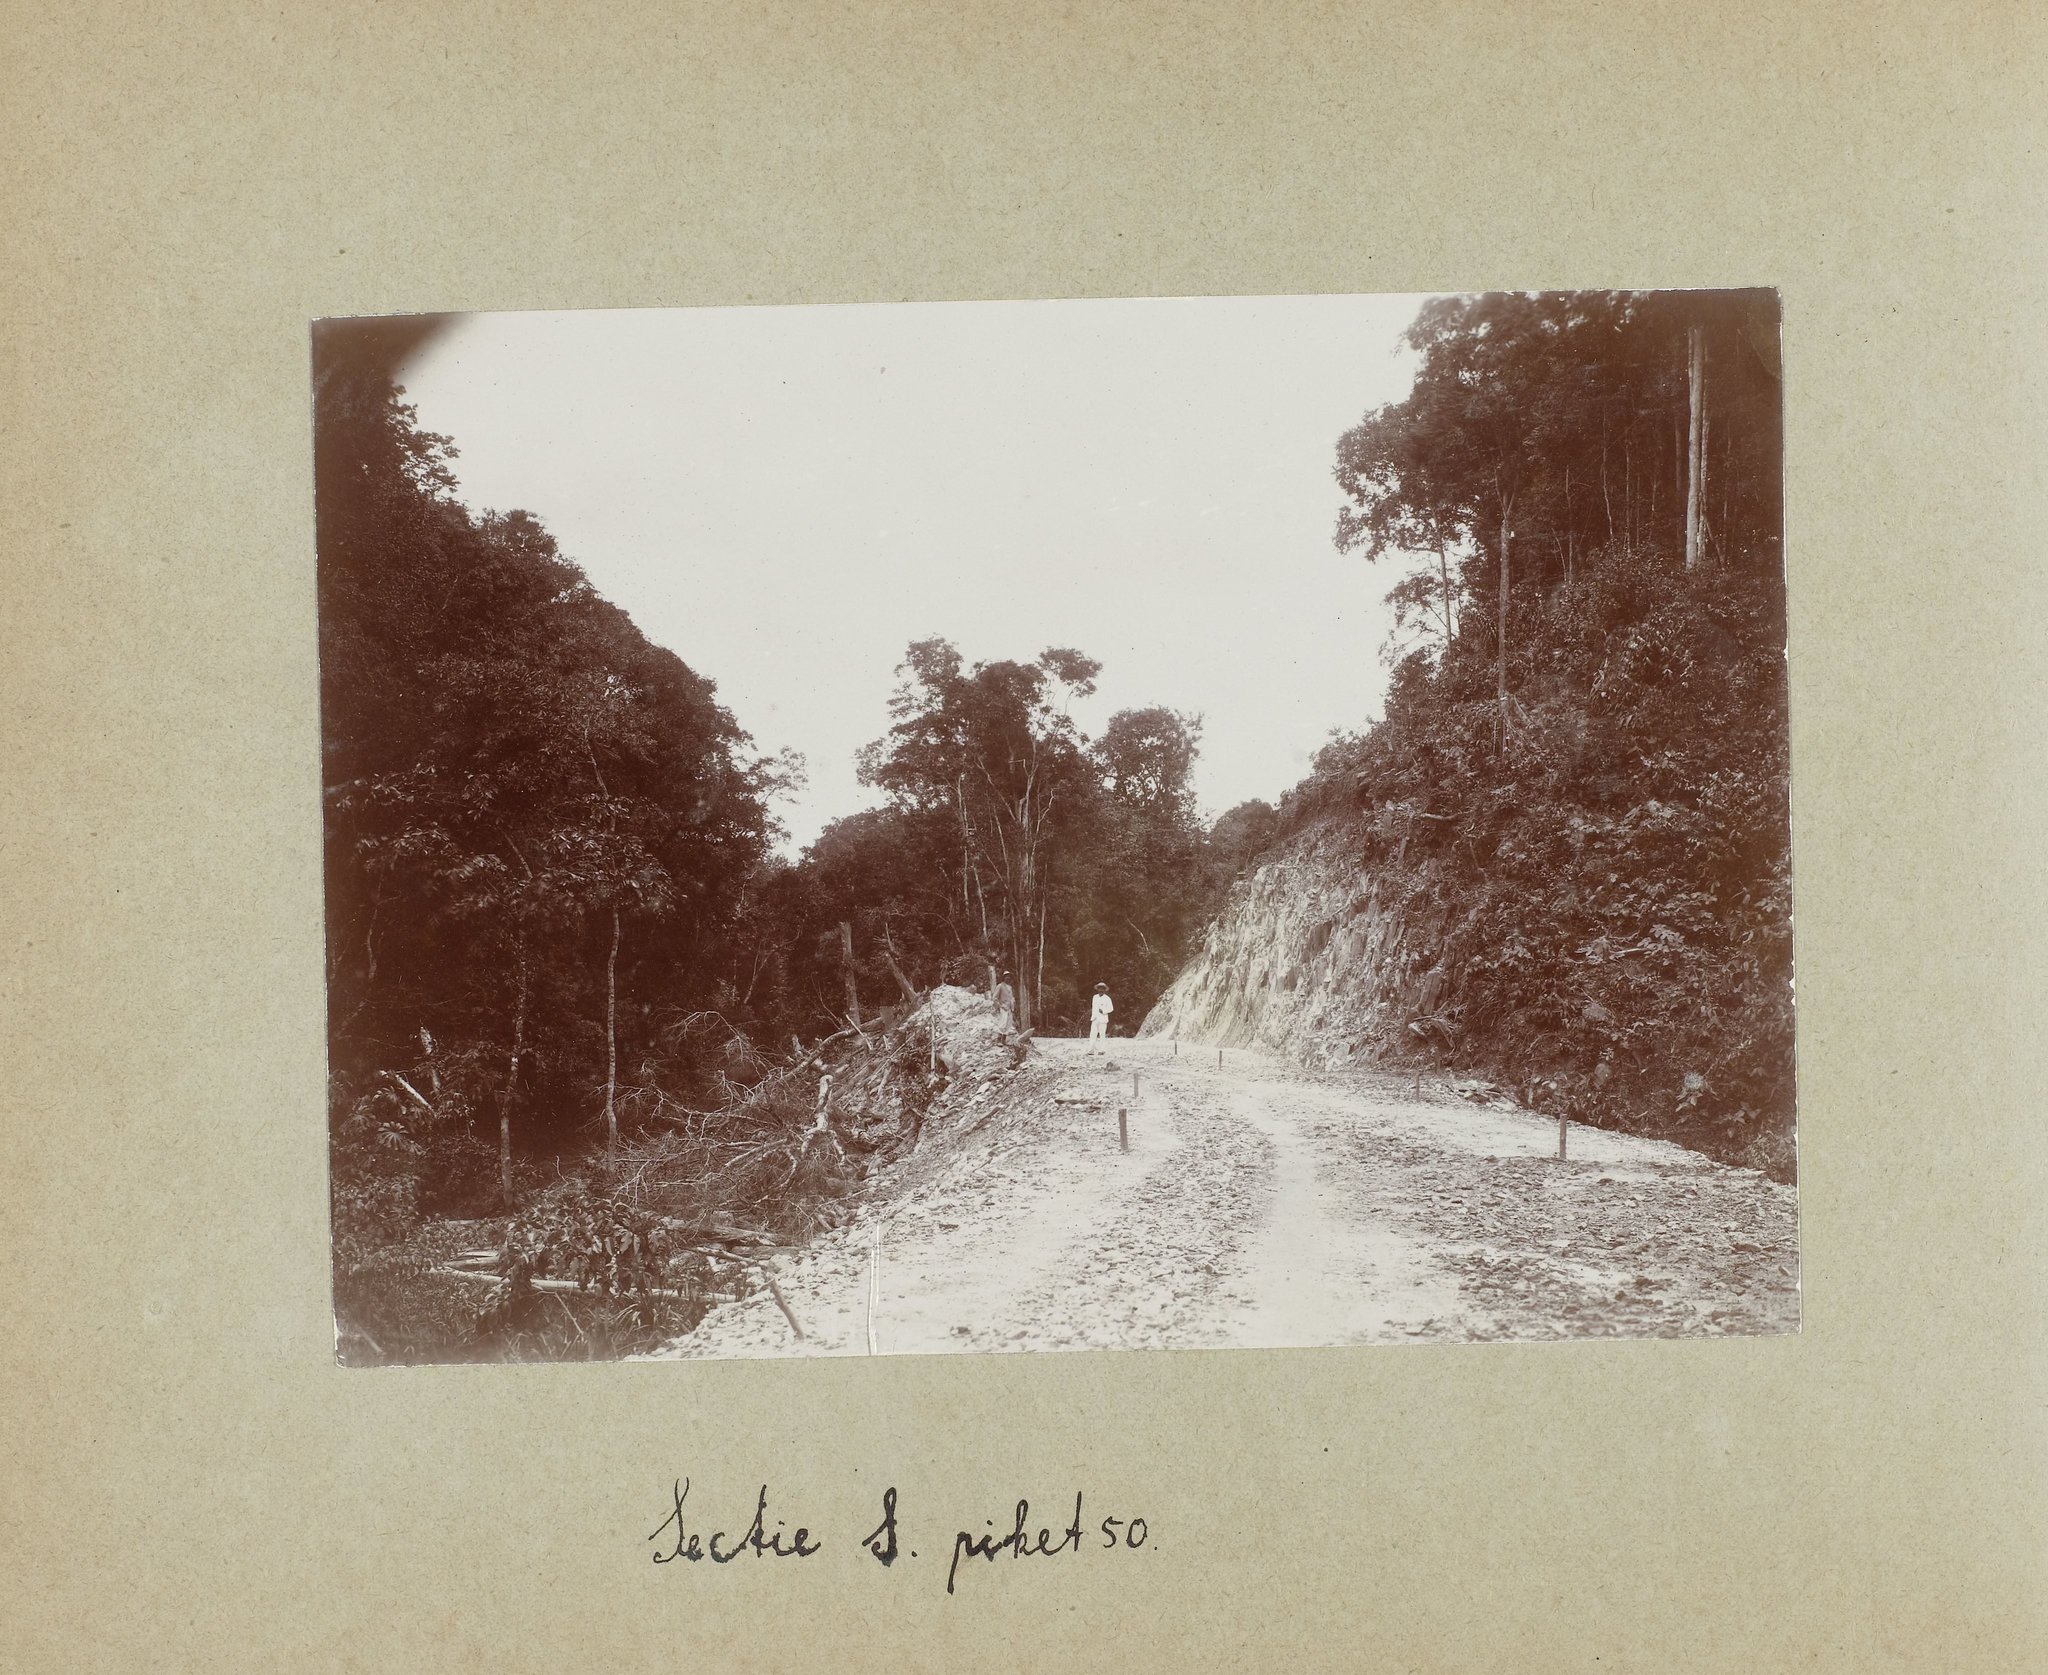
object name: photograph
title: Sectie S - piket 50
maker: augusta curiel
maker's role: fotograaf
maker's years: 1873-1937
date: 1905-1910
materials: photographic support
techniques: photography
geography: suriname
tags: jacob evert wesenhagen, railway, tramway; rack railway, suriname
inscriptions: inscription: ‘Sectie S - piket 50’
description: Grondwerkzaamheden in sectie S. Foto in het fotoalbum over de aanleg van de Lawaspoorweg in Suriname in de jaren 1903-1912. Onderdeel van een groep objecten afkomstig van de familie Wesenhagen in Suriname.